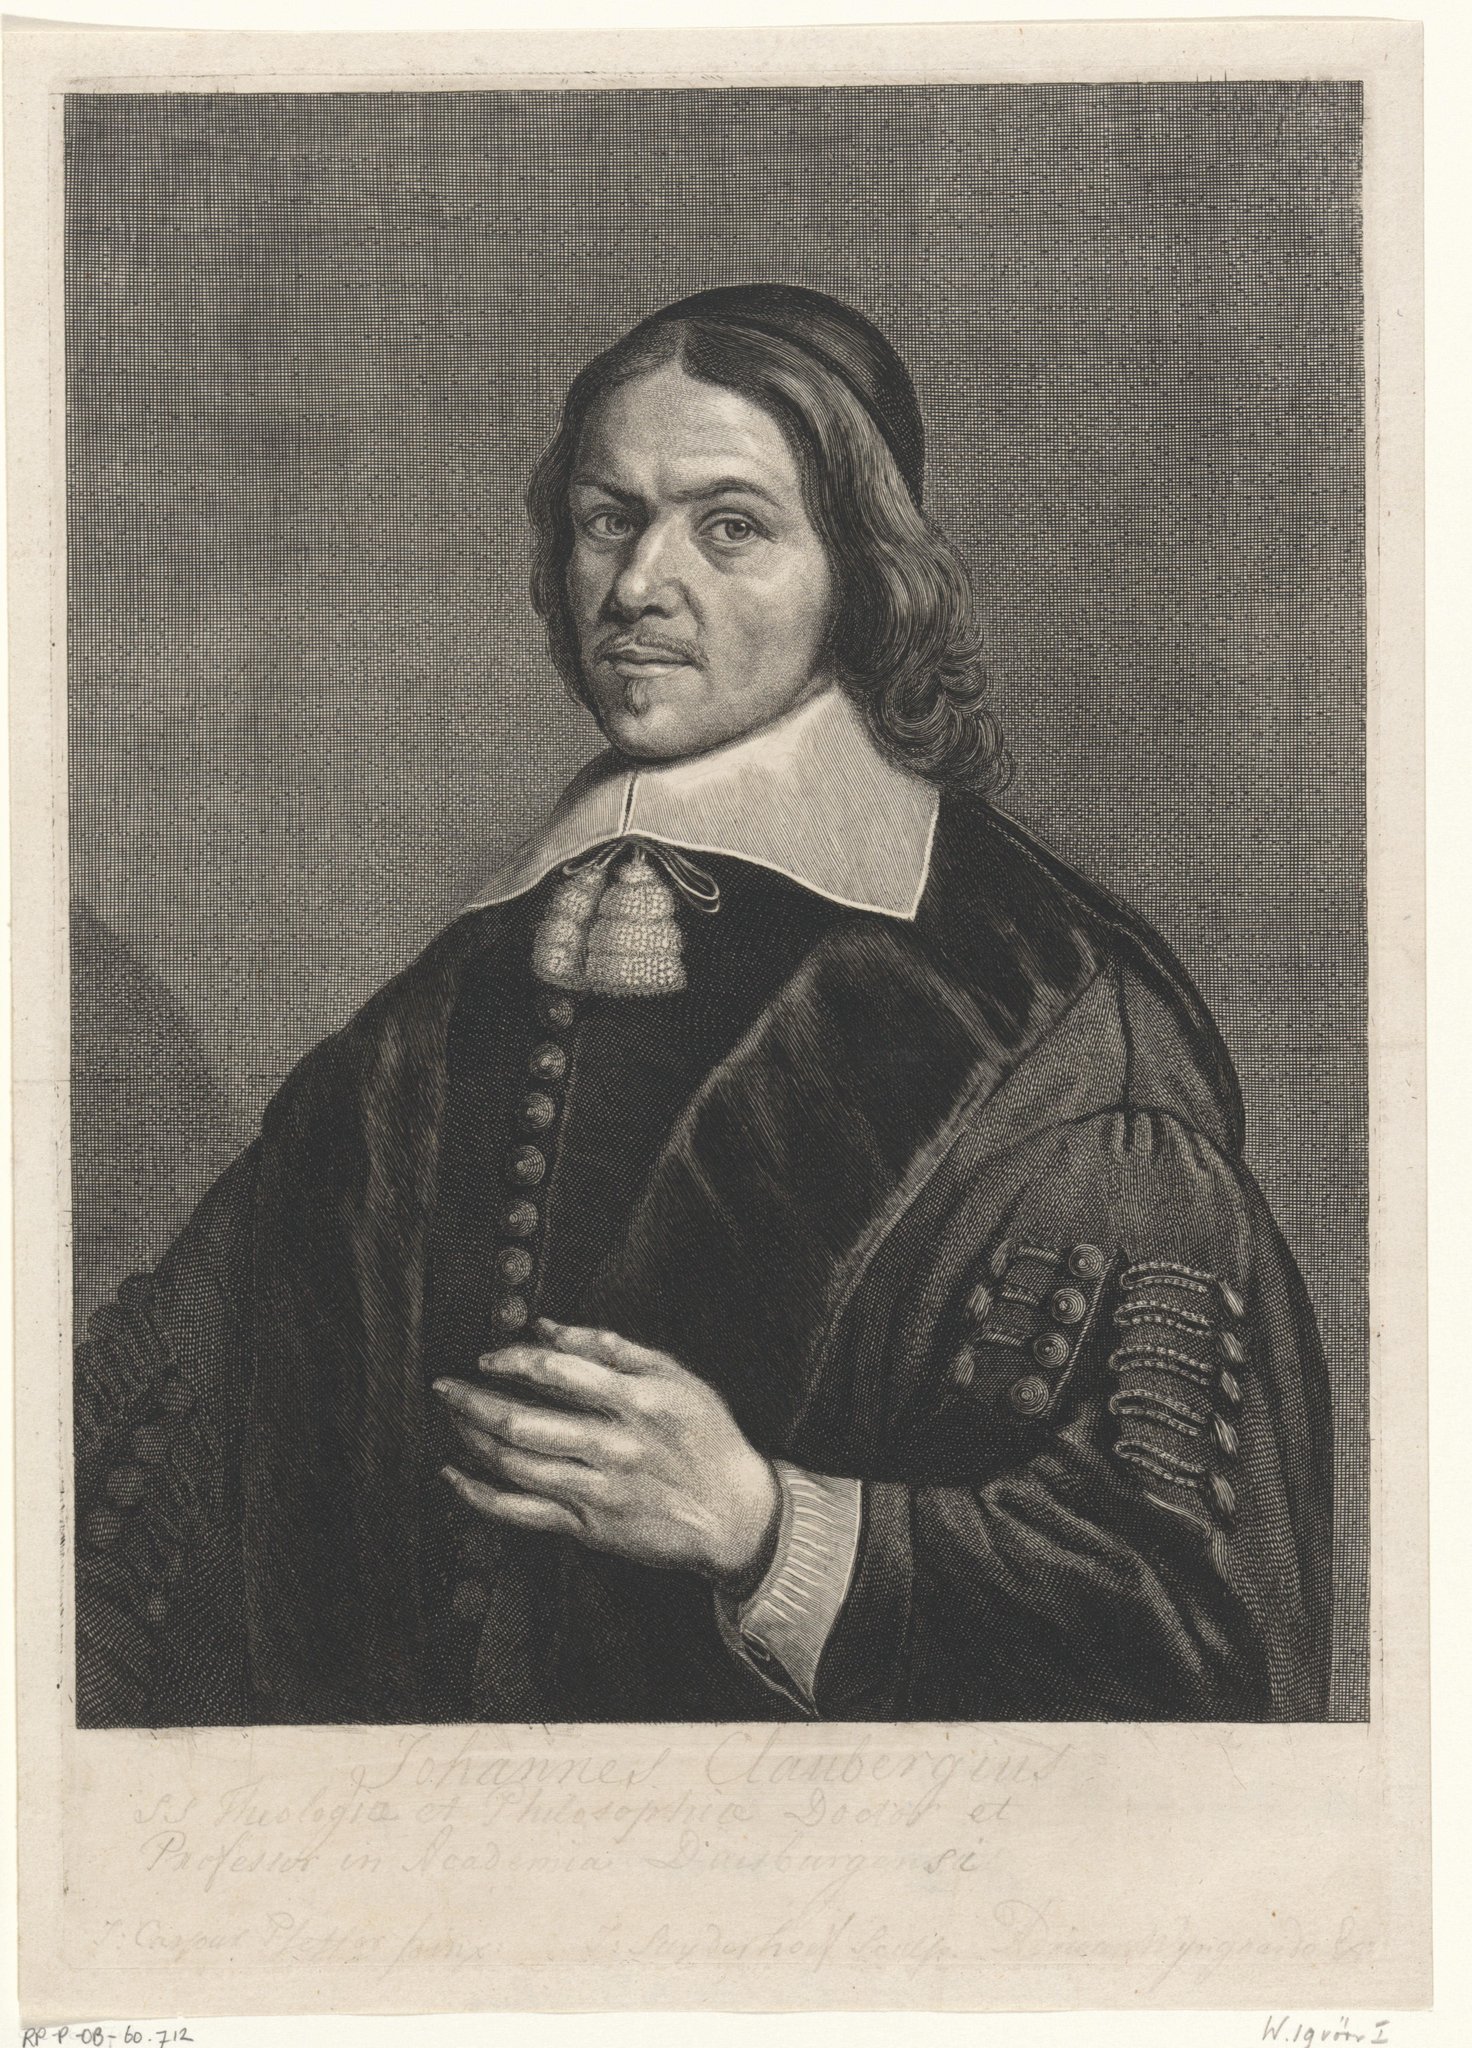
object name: print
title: Portret van Johannes Clauberg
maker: jonas suyderhoef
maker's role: draughtsman, print maker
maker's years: 1613-1686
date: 1655-1665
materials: paper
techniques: engraving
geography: haarlem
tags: solingen, scholar, philosopher, professor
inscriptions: collector's mark: Lugt 240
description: Portret van Johannes Clauberg, hoogleraar theologie en filosofie aan de door hem gestichtte eerste universiteit van Duisburg.